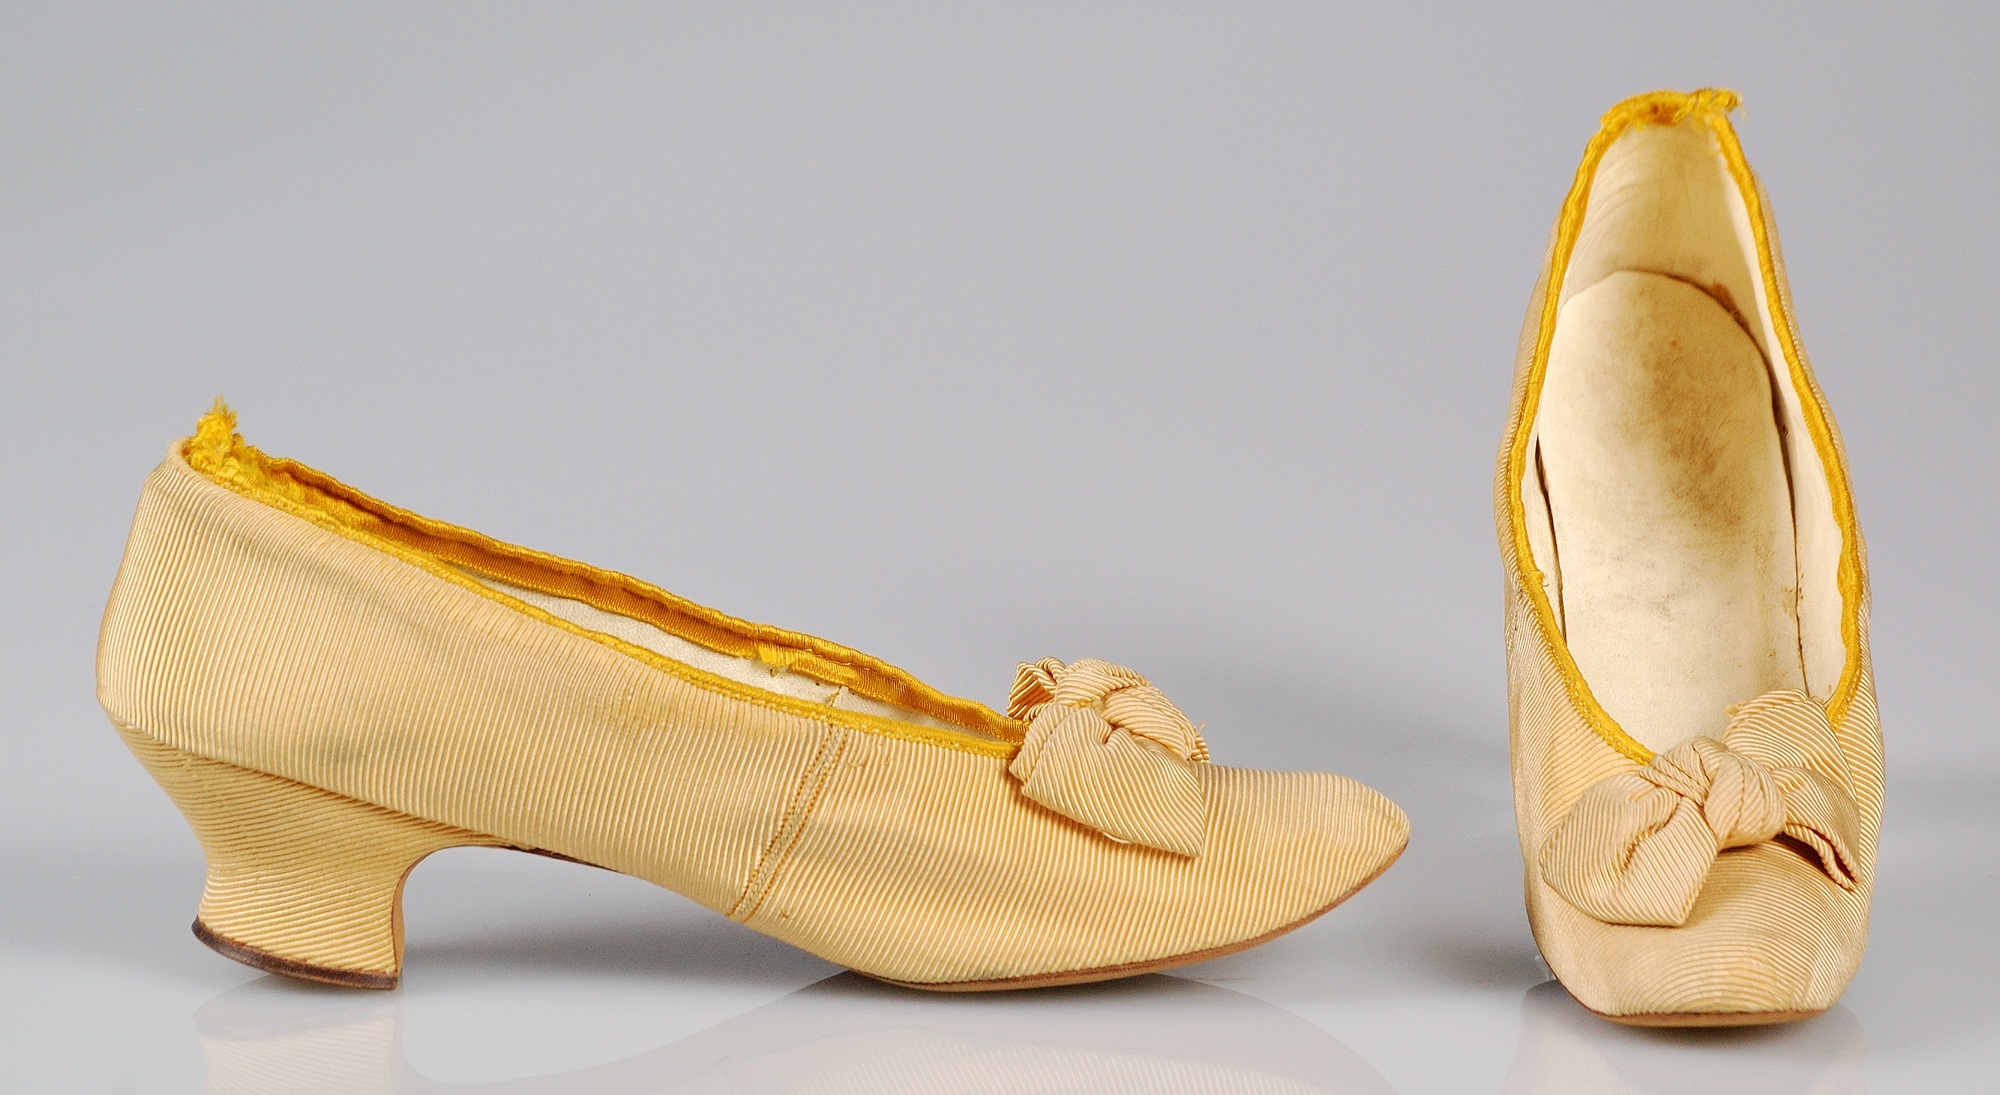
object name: evening pump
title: Evening pumps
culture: french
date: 1885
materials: silk